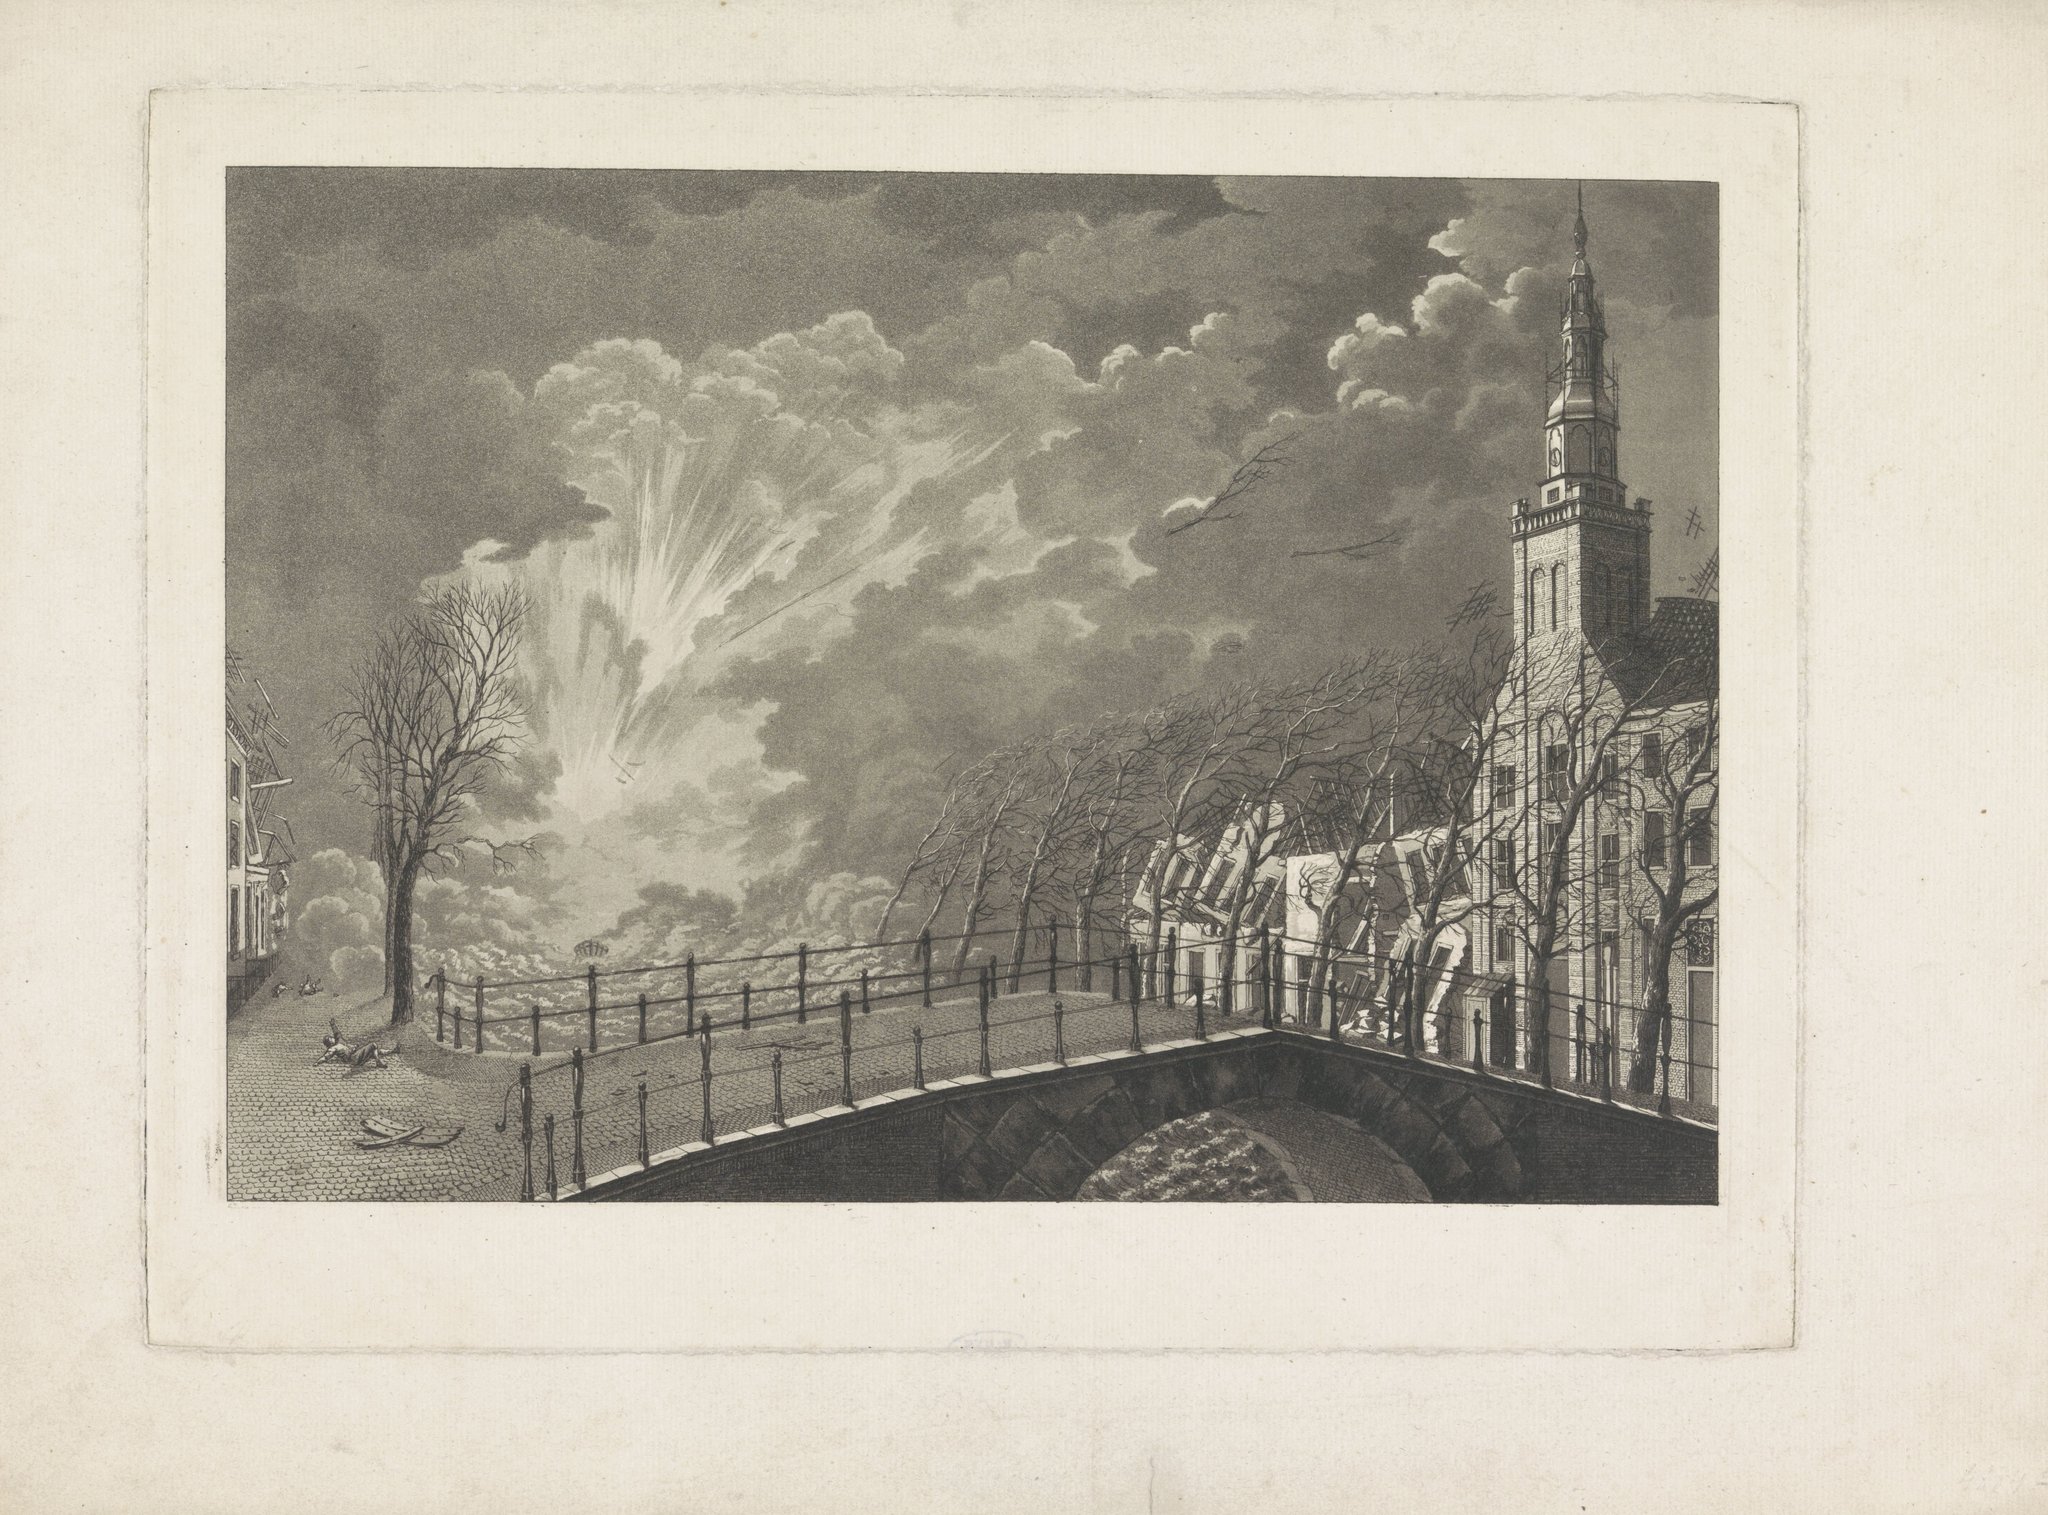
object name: print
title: Vier platen van de Leidse buskruitramp van 1807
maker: friedrich christoph dietrich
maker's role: print maker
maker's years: 1779-1847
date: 1807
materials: paper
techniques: aquatint, etching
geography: netherlands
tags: gunpowder disaster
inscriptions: collector's mark: Lugt 2228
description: De ontploffing van het schip met buskruit op het het Steenschuur, een gracht in het verlengde van het Rapenburg, te Leiden, de buskruitramp van 12 januari 1807. Rechts de Saaihal of Sint Lodewijkskerk.